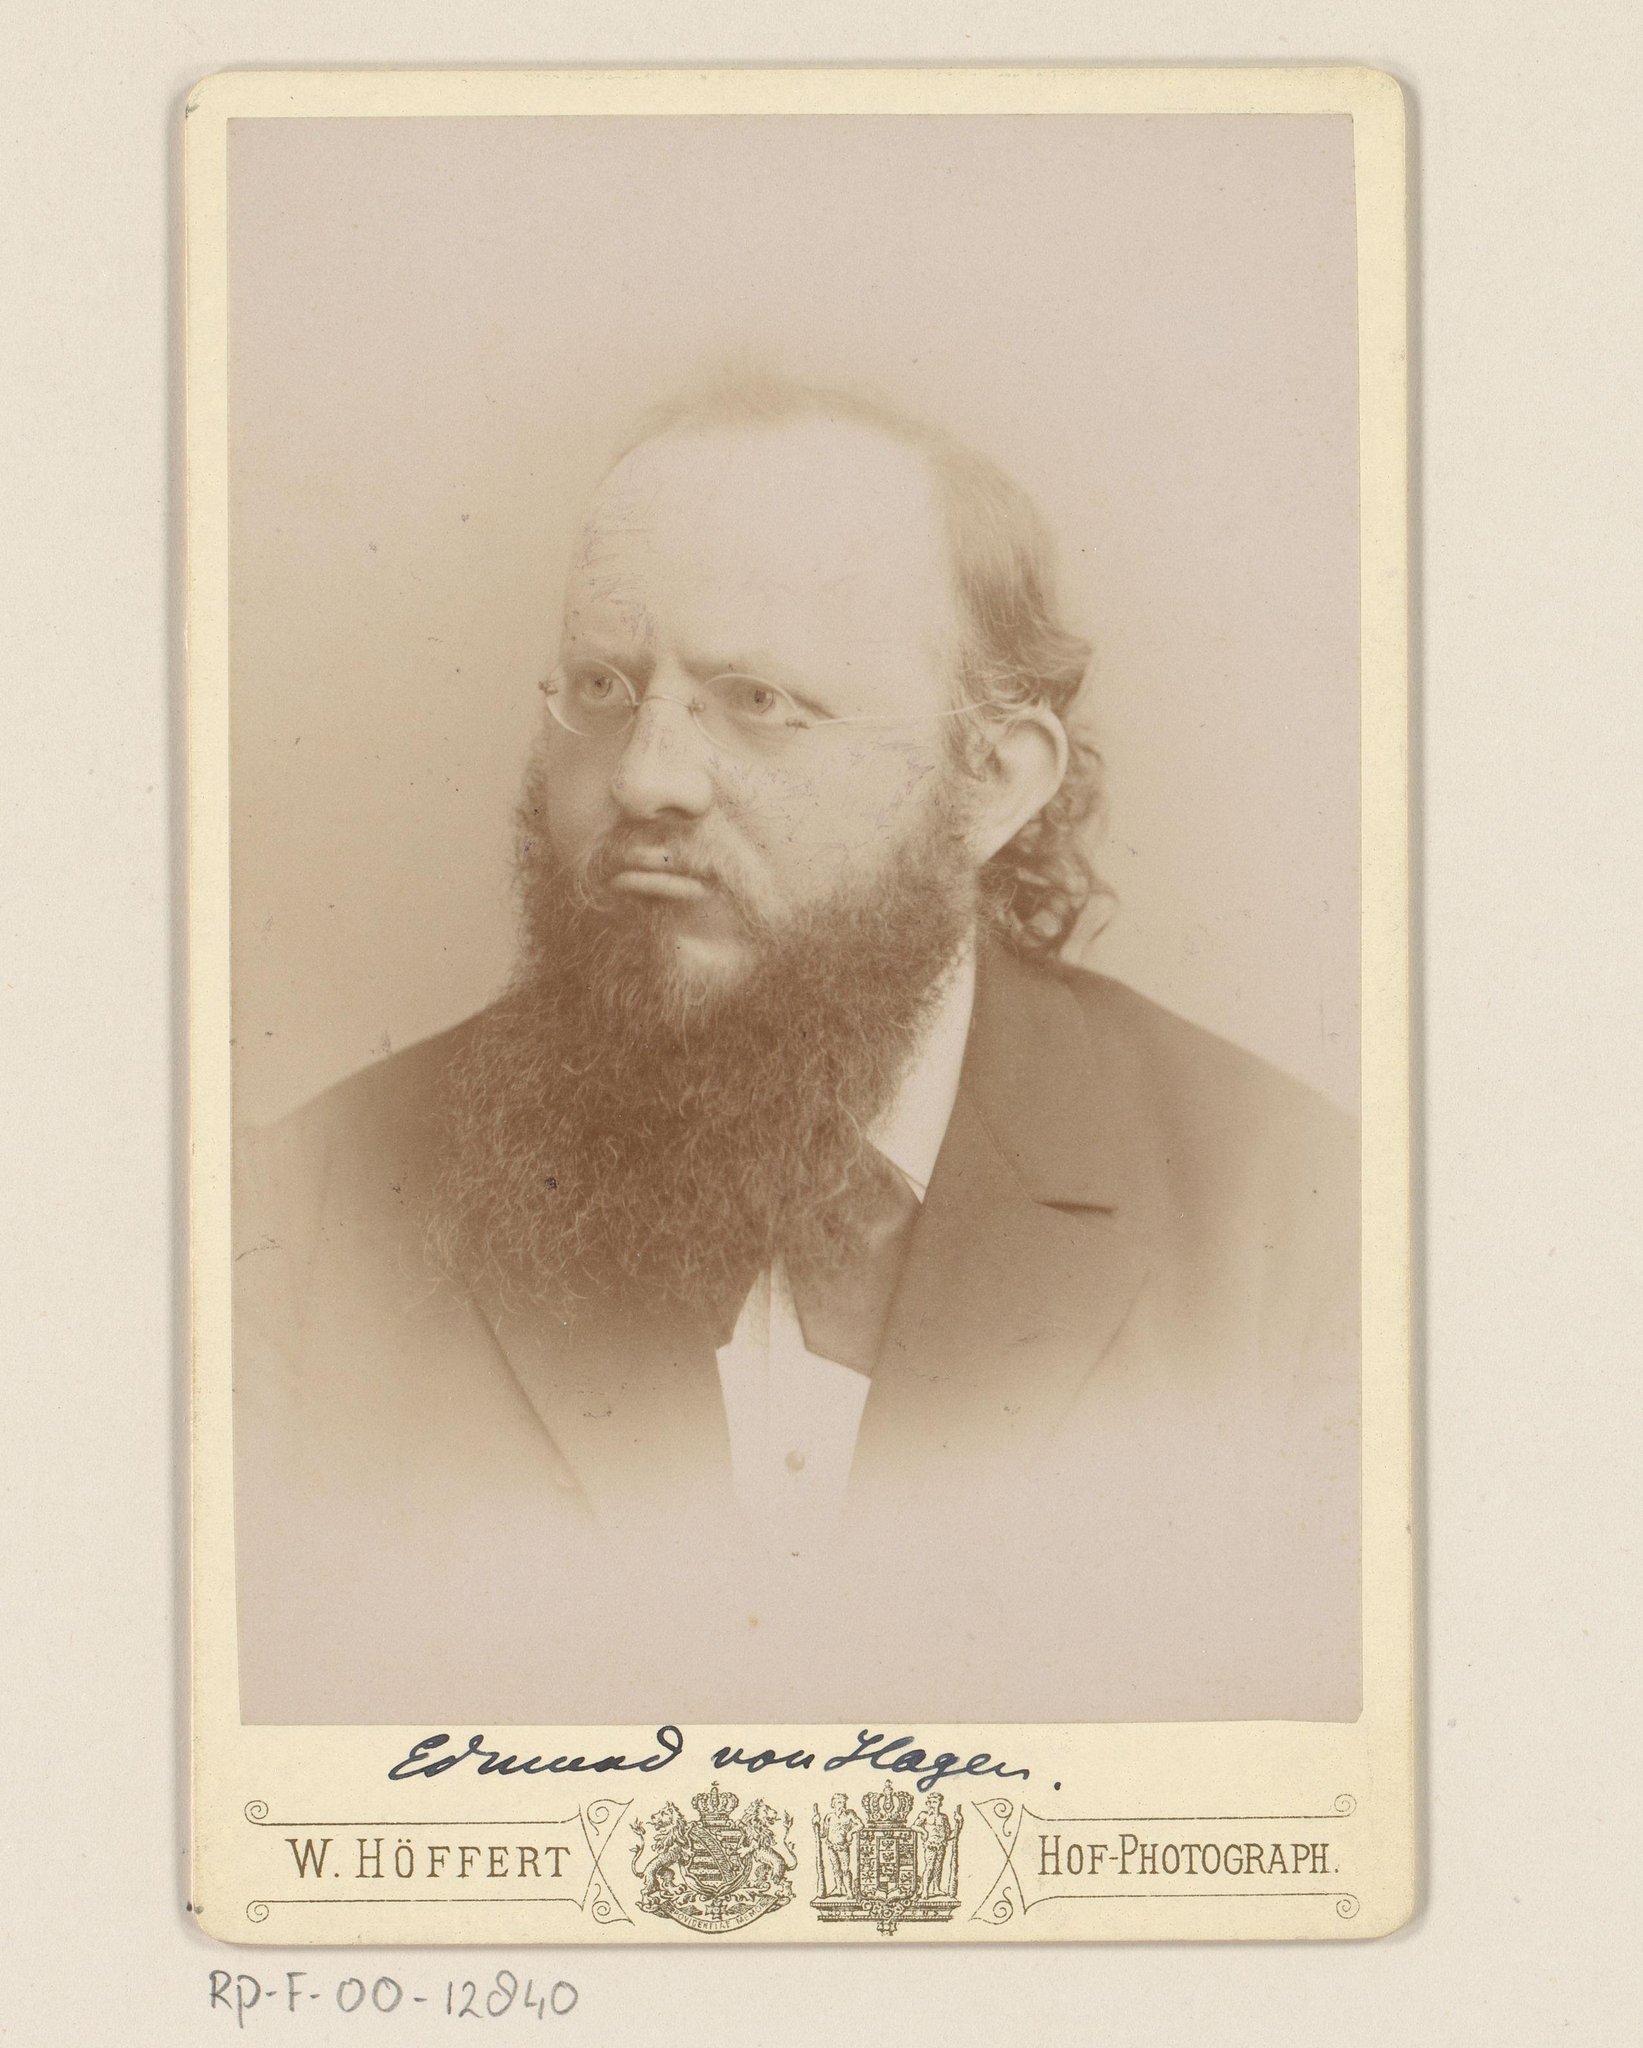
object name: photograph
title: Portret van Edmund von Hagen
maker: wilhelm höffert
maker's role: fotograaf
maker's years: 1832-1901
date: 1874-1907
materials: cardboard, paper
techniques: albumen print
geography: germany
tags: historical persons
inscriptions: inscription: ‘Edmund von Hagen.’, inscription: ‘W. Höffert/ Koningl. Sch & Königl. Preuss Hof-Photograph/ HANNOVER/ Georgstrasse 9./ DRESDEN/ See-Str. 1-, Kaufhaus/ BERLIN/ Leipziger-Platz No. 12n./ LEIPZIG/ Schlossgasse 1, Petersbrücke./ HAMBURG/ Jungfernstieg No. 6.’